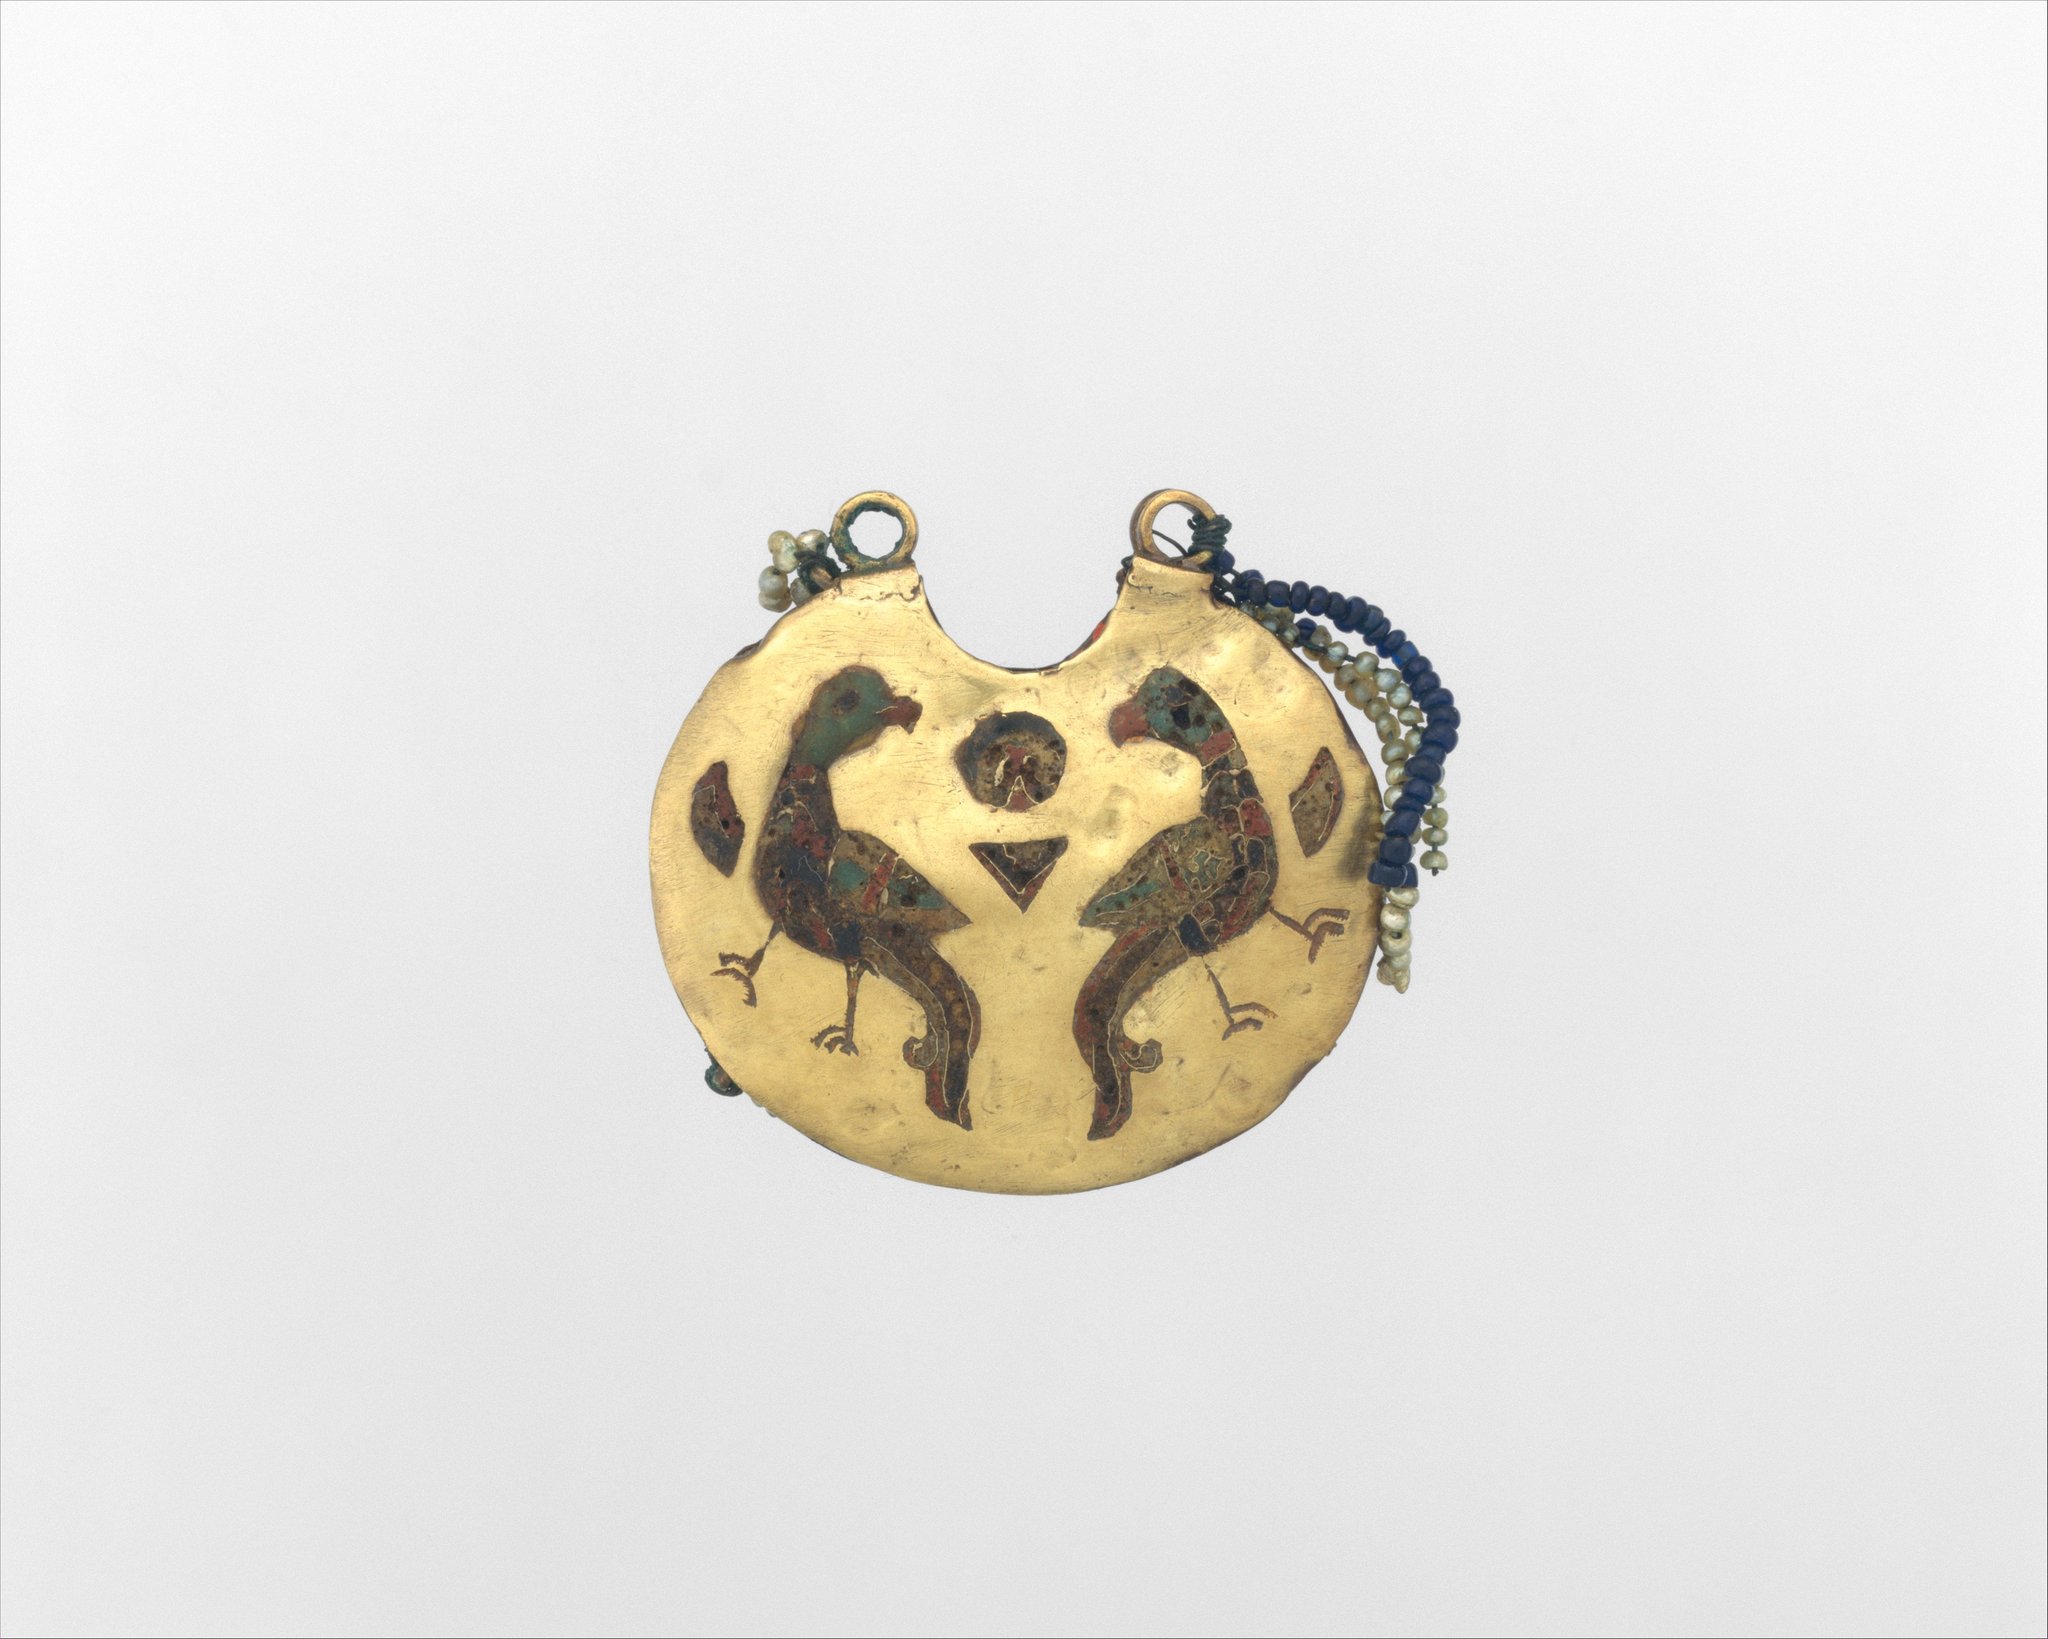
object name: temple pendant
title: One of a Pair of Temple Pendants, with Confronted Birds (front) and Human Heads (back)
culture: kyivan rus’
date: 1001-1200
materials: enamel, pearl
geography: ukraine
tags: birds,heads